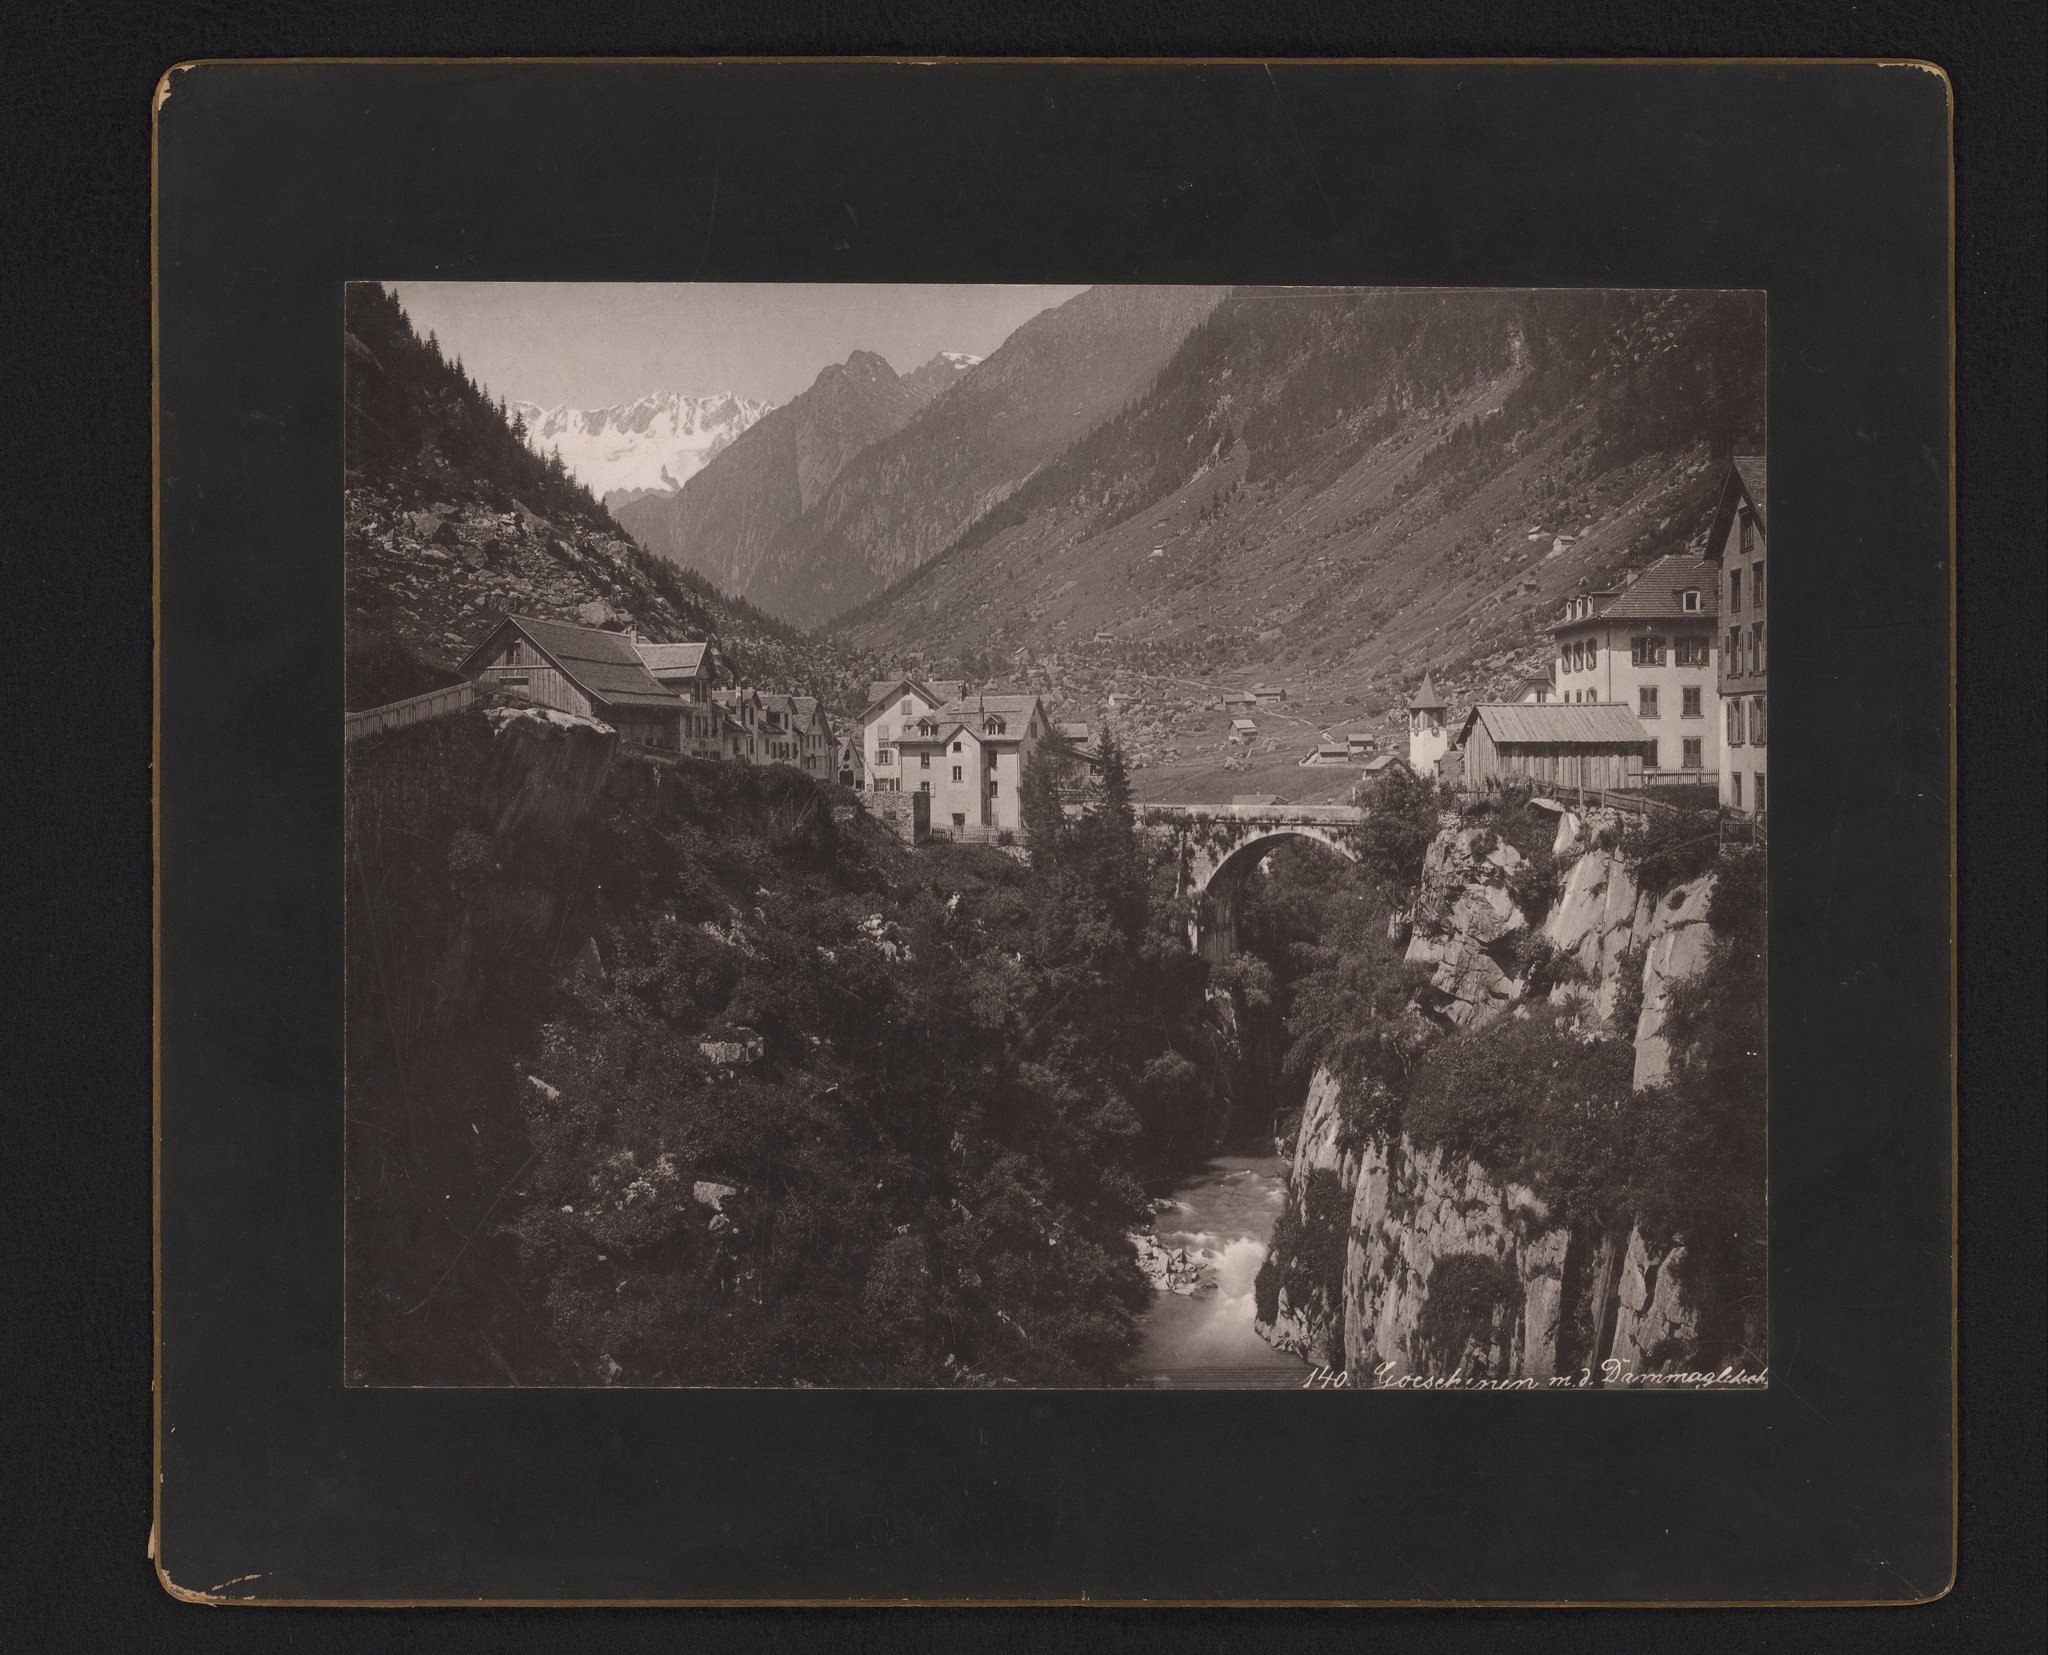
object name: photomechanical print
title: Gezicht op Göschenen en de Dammagletsjer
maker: Anonymous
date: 1890-1910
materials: cardboard, paper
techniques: photograph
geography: göschenen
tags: village, glacier, mountains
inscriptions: inscription: ‘140. Goeschenen m.d. Dammagletsch.’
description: Deze fotomechanische afdruk maakt deel uit van een omslag.